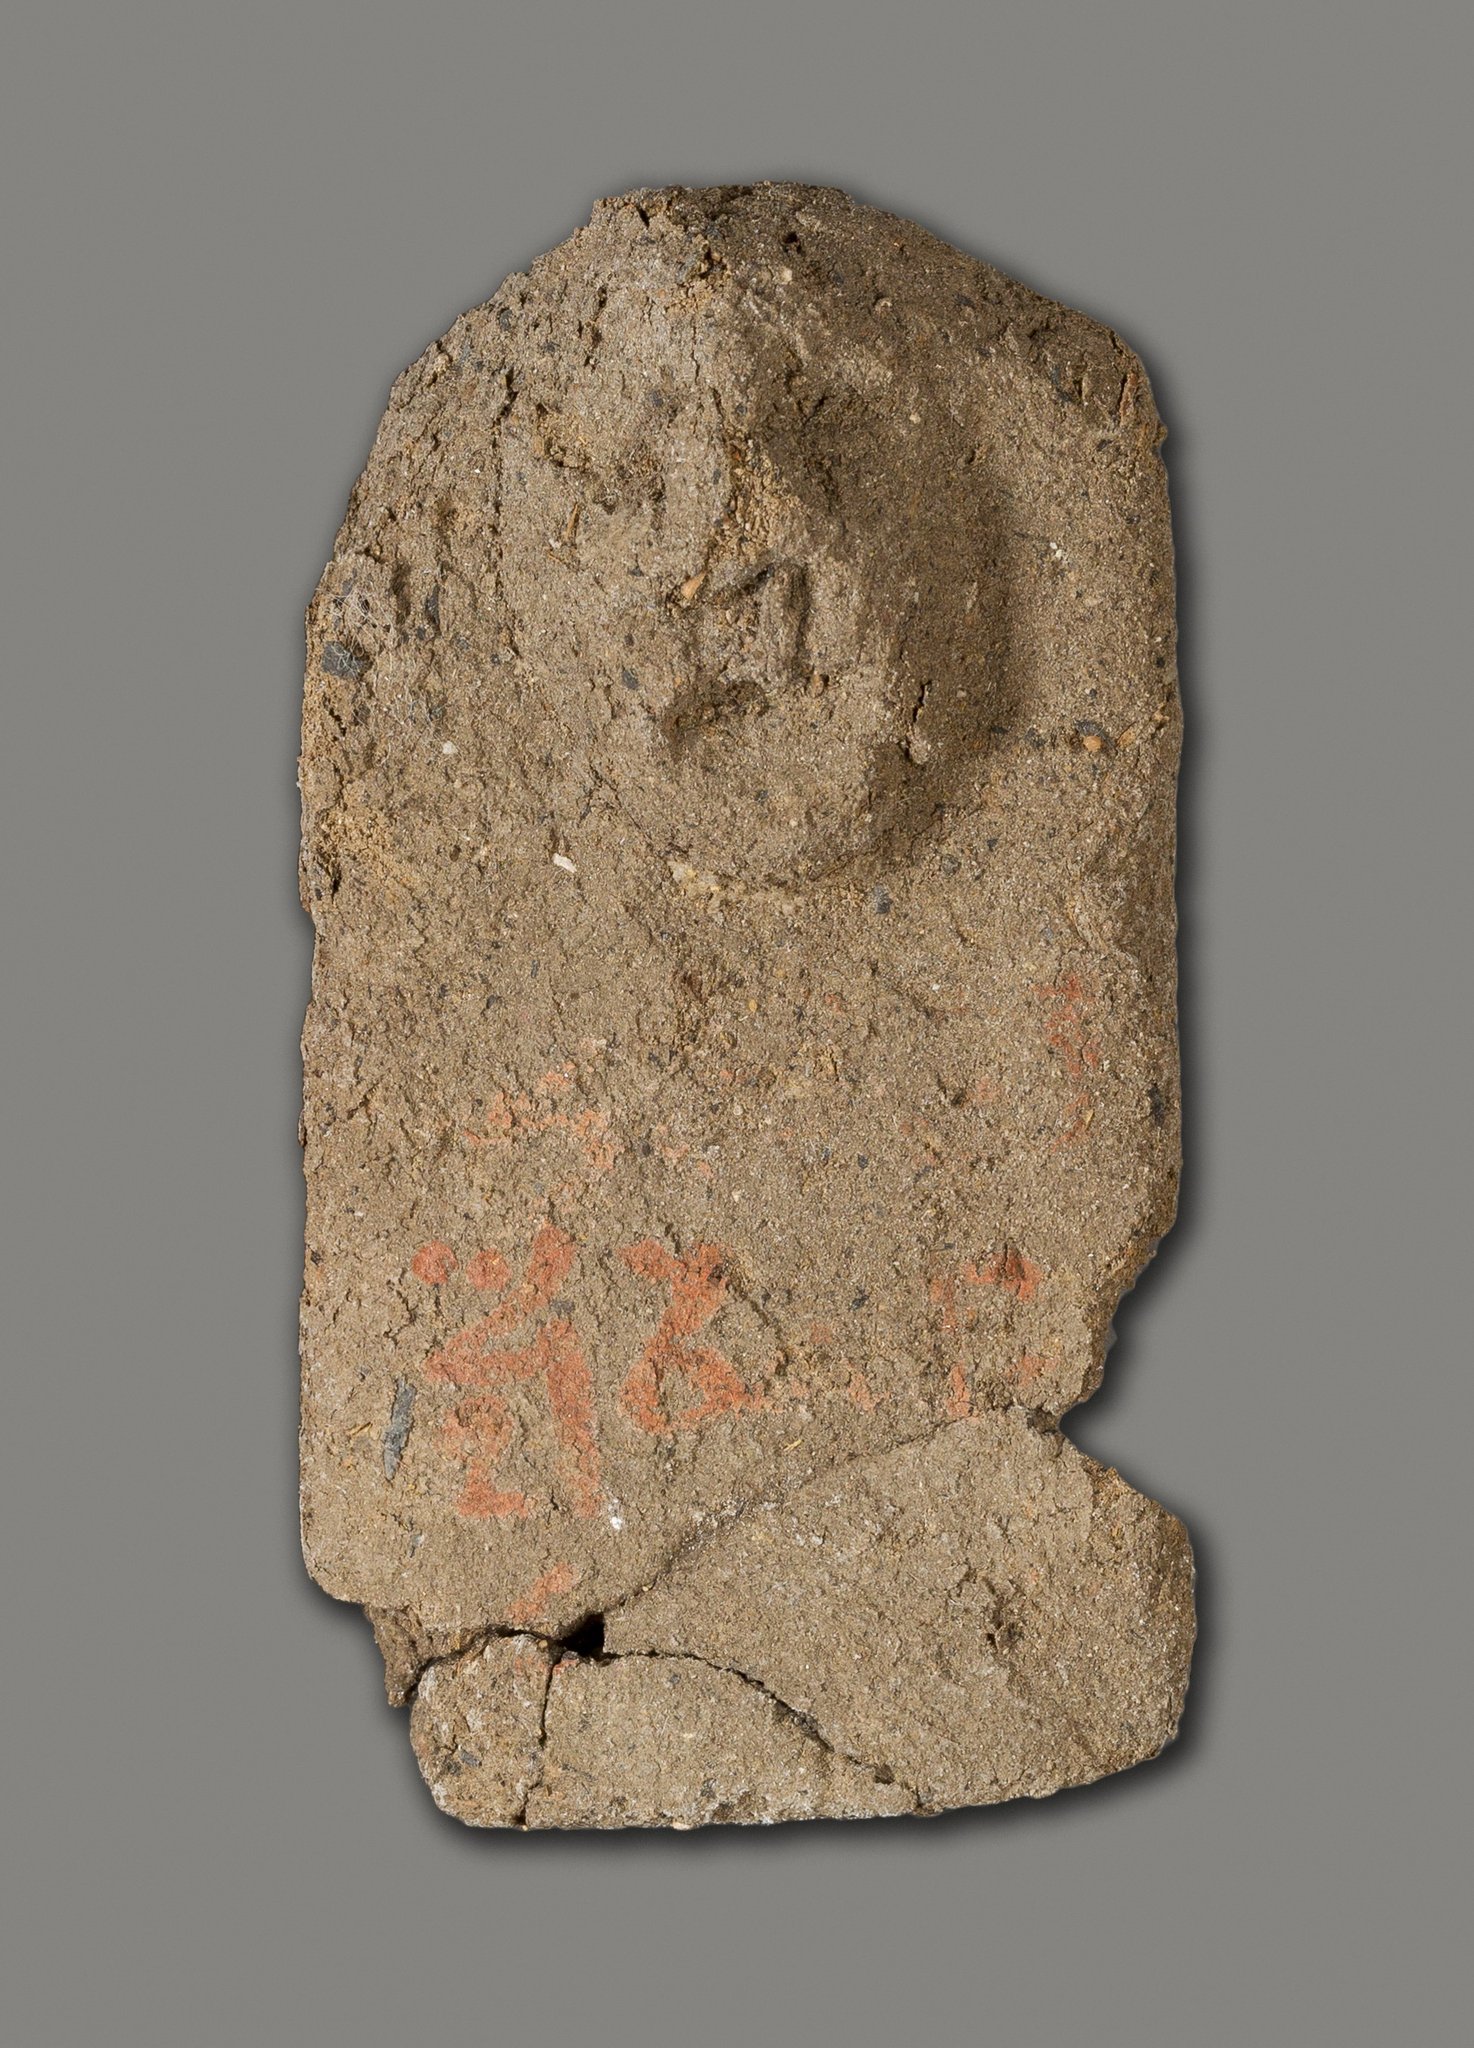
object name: figure, magical, execration, tablet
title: Magical Figure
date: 1802-1550 BCE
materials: clay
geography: egypt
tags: faces